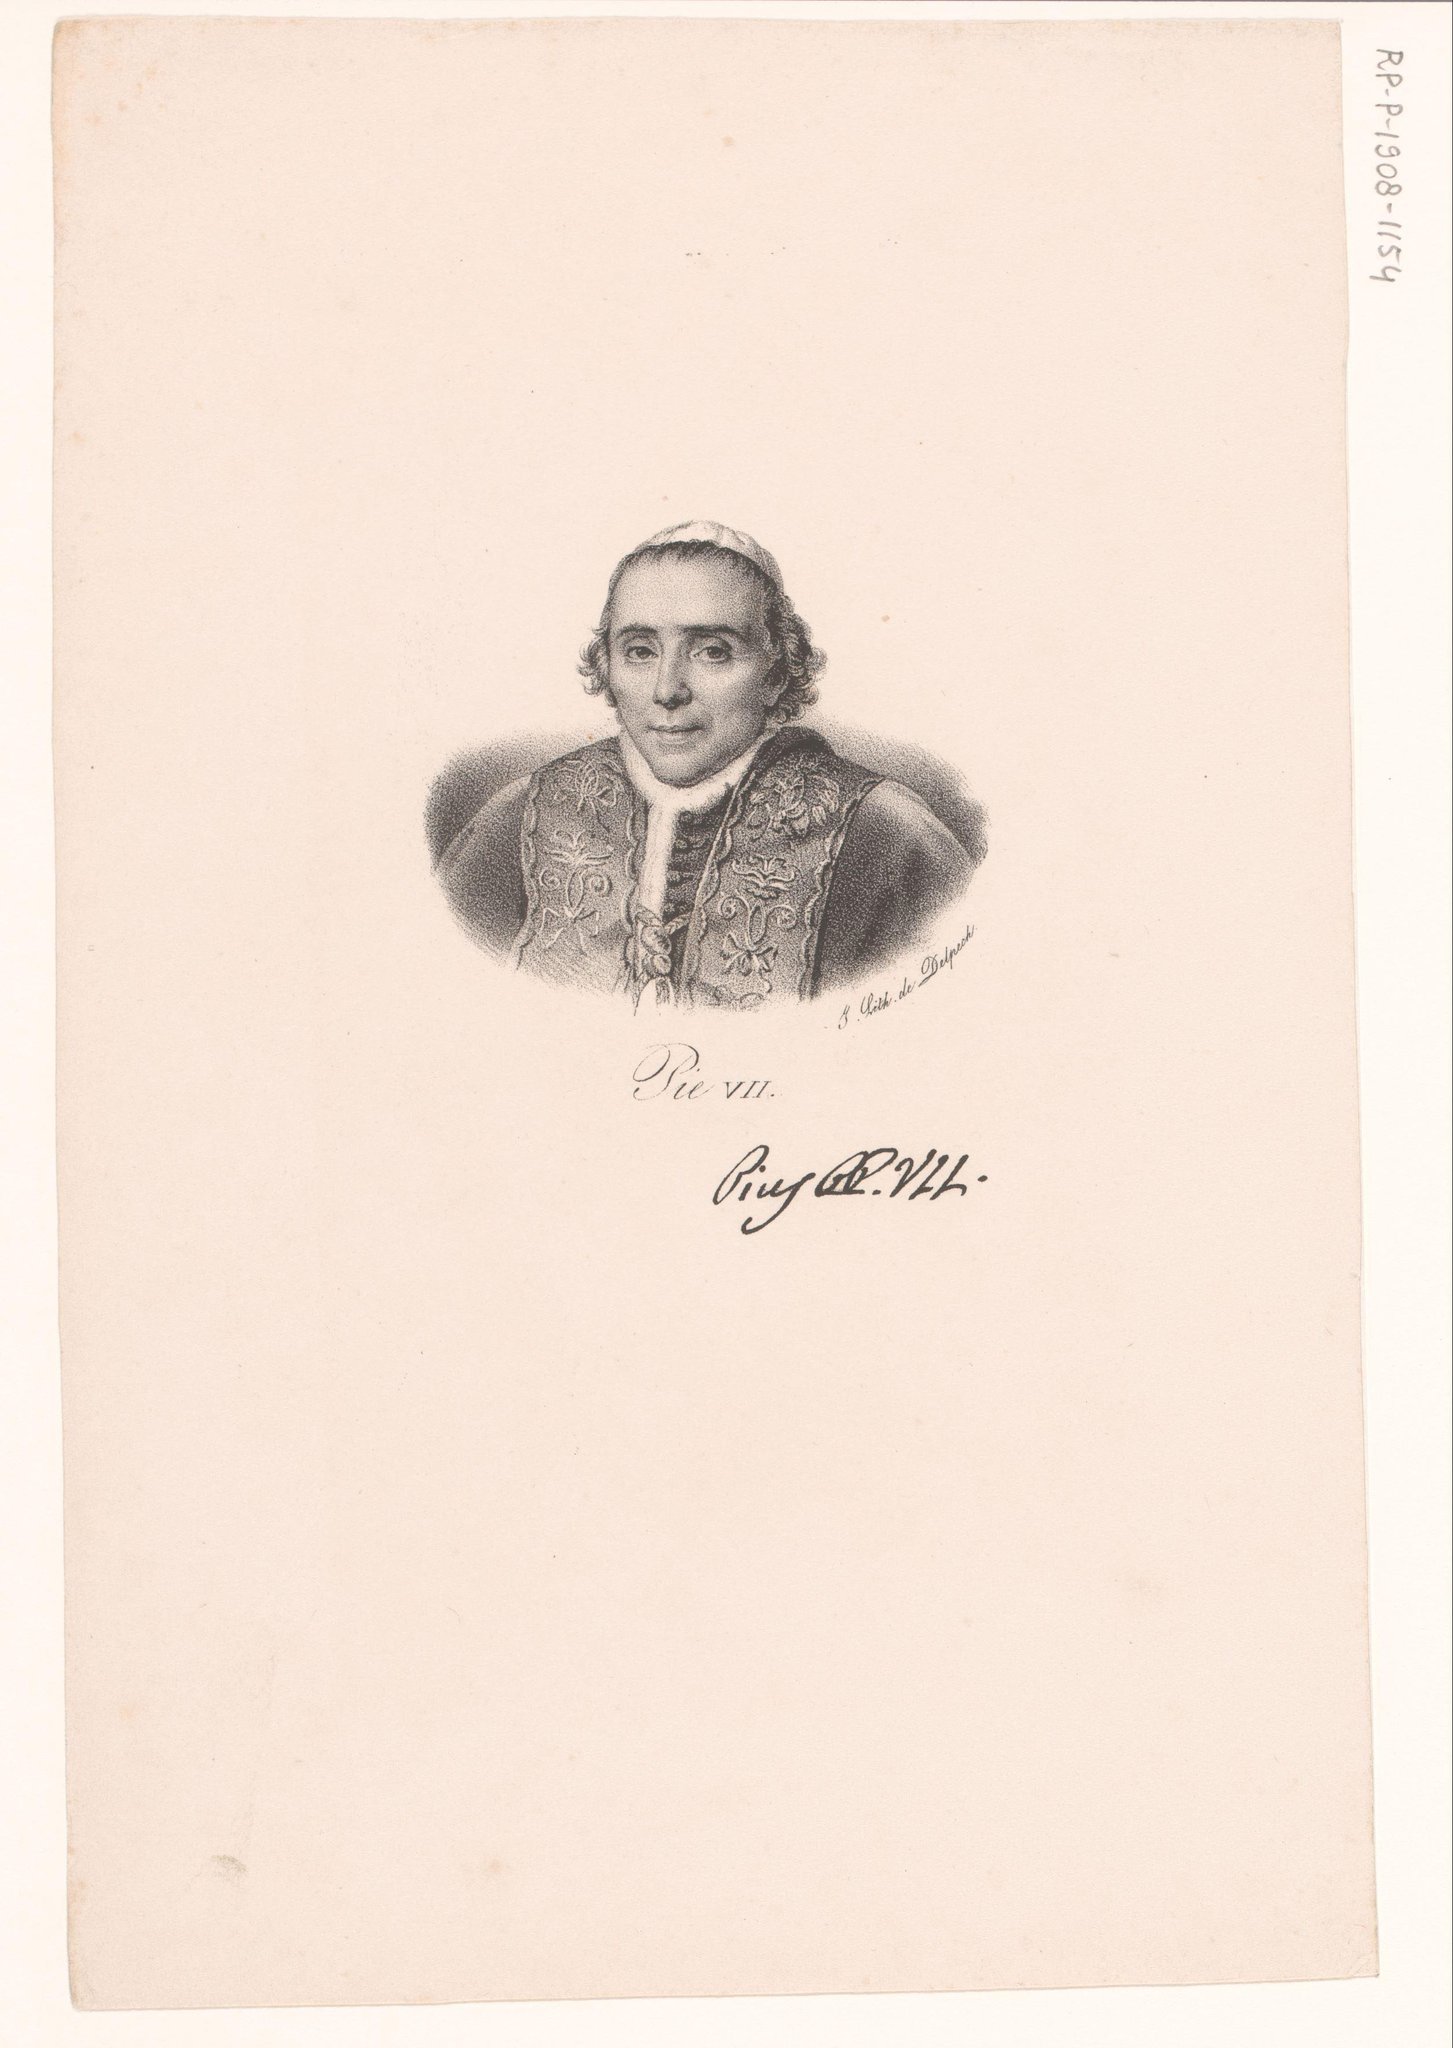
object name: print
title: Pie VII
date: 1818-1842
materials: paper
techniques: lithograph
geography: paris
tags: rome, clergyman, pius vii, historical persons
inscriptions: collector's mark: Lugt 2228a